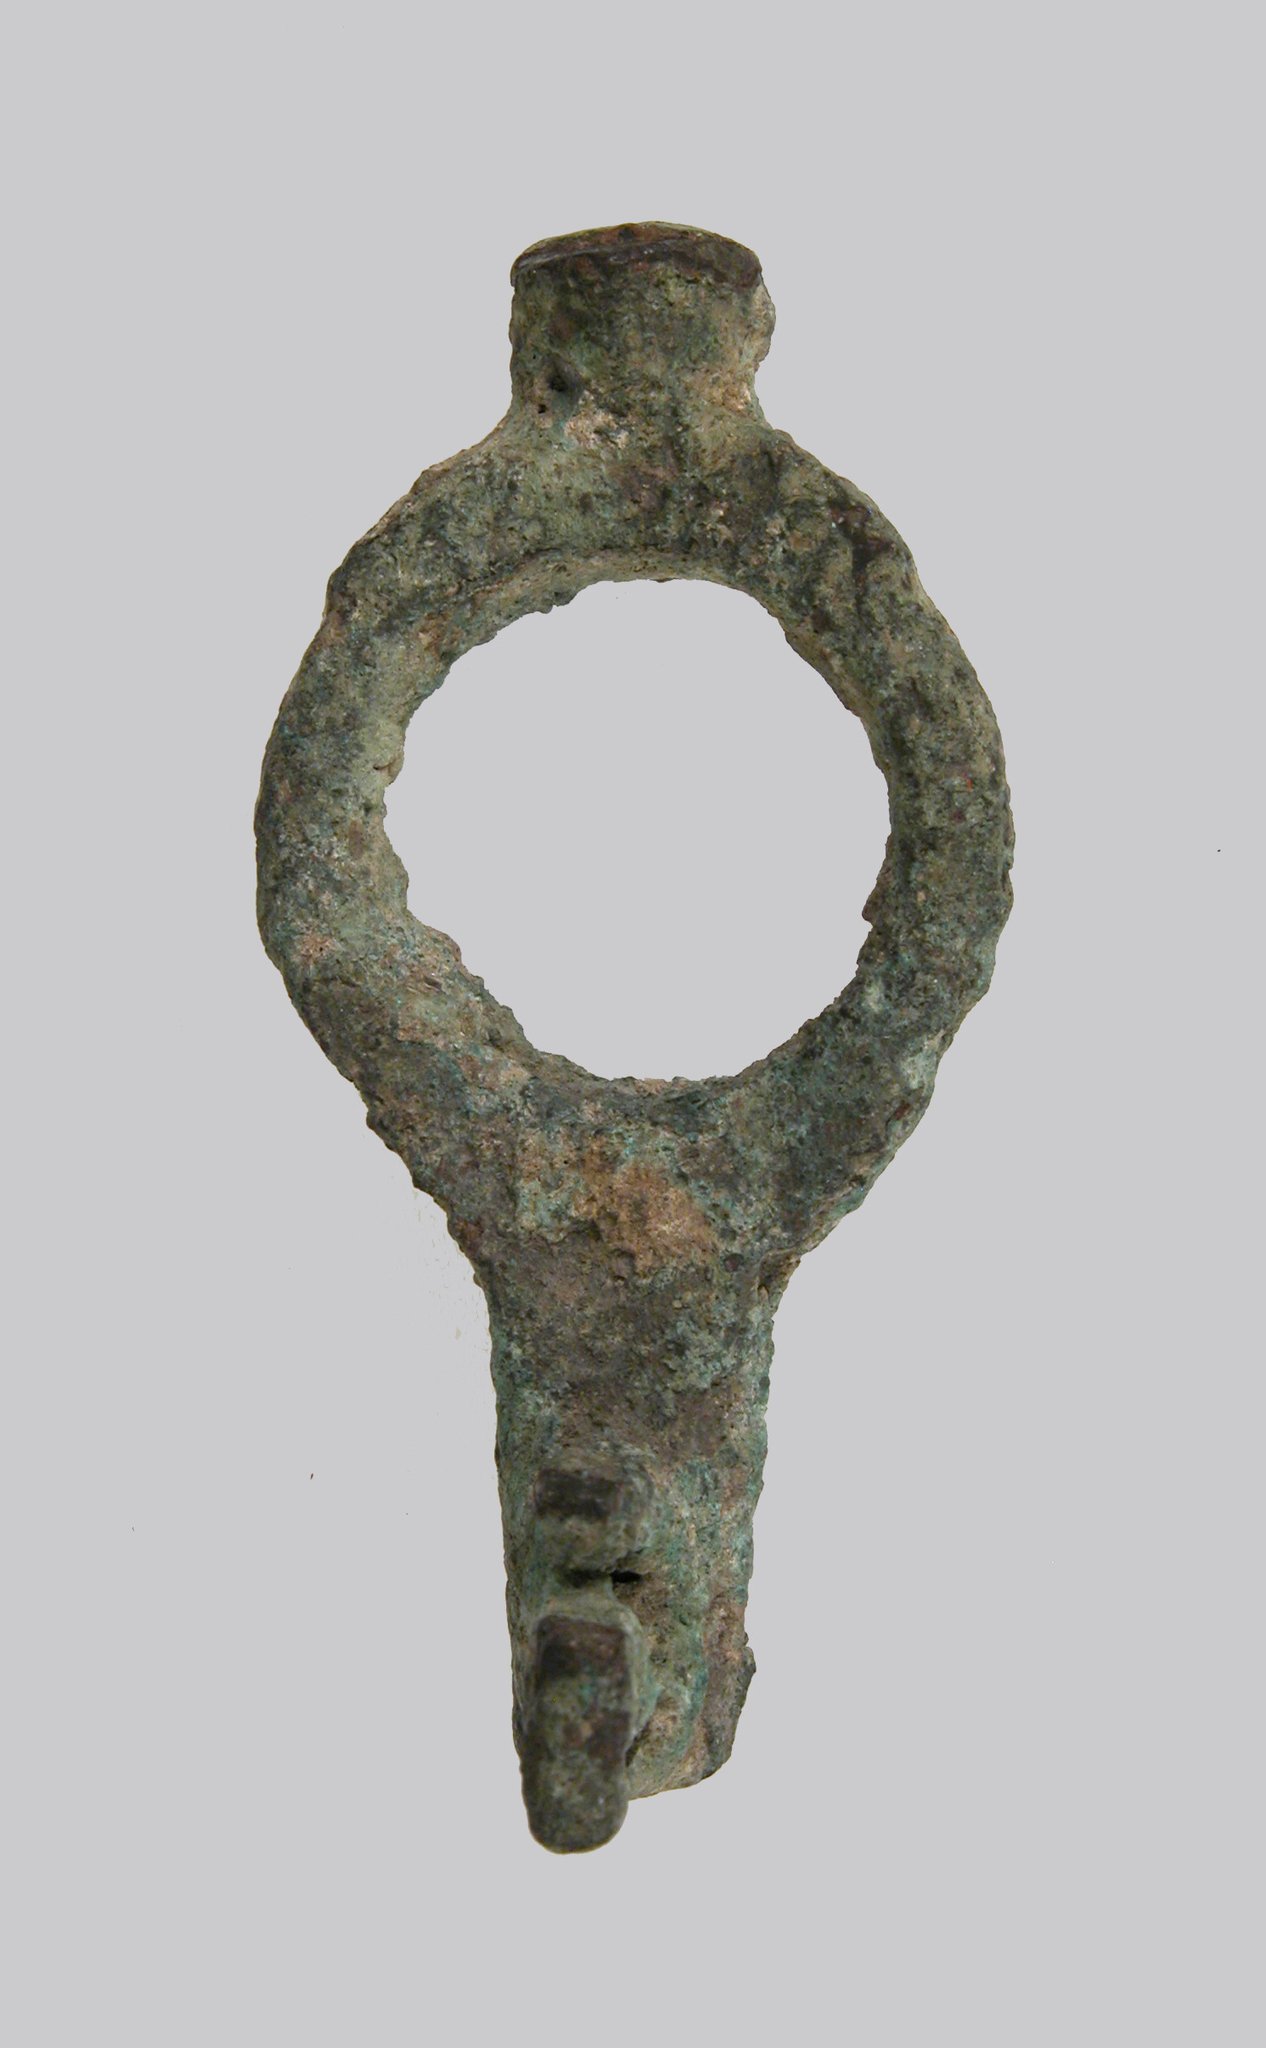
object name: key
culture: roman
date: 1-300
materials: copper alloy, iron